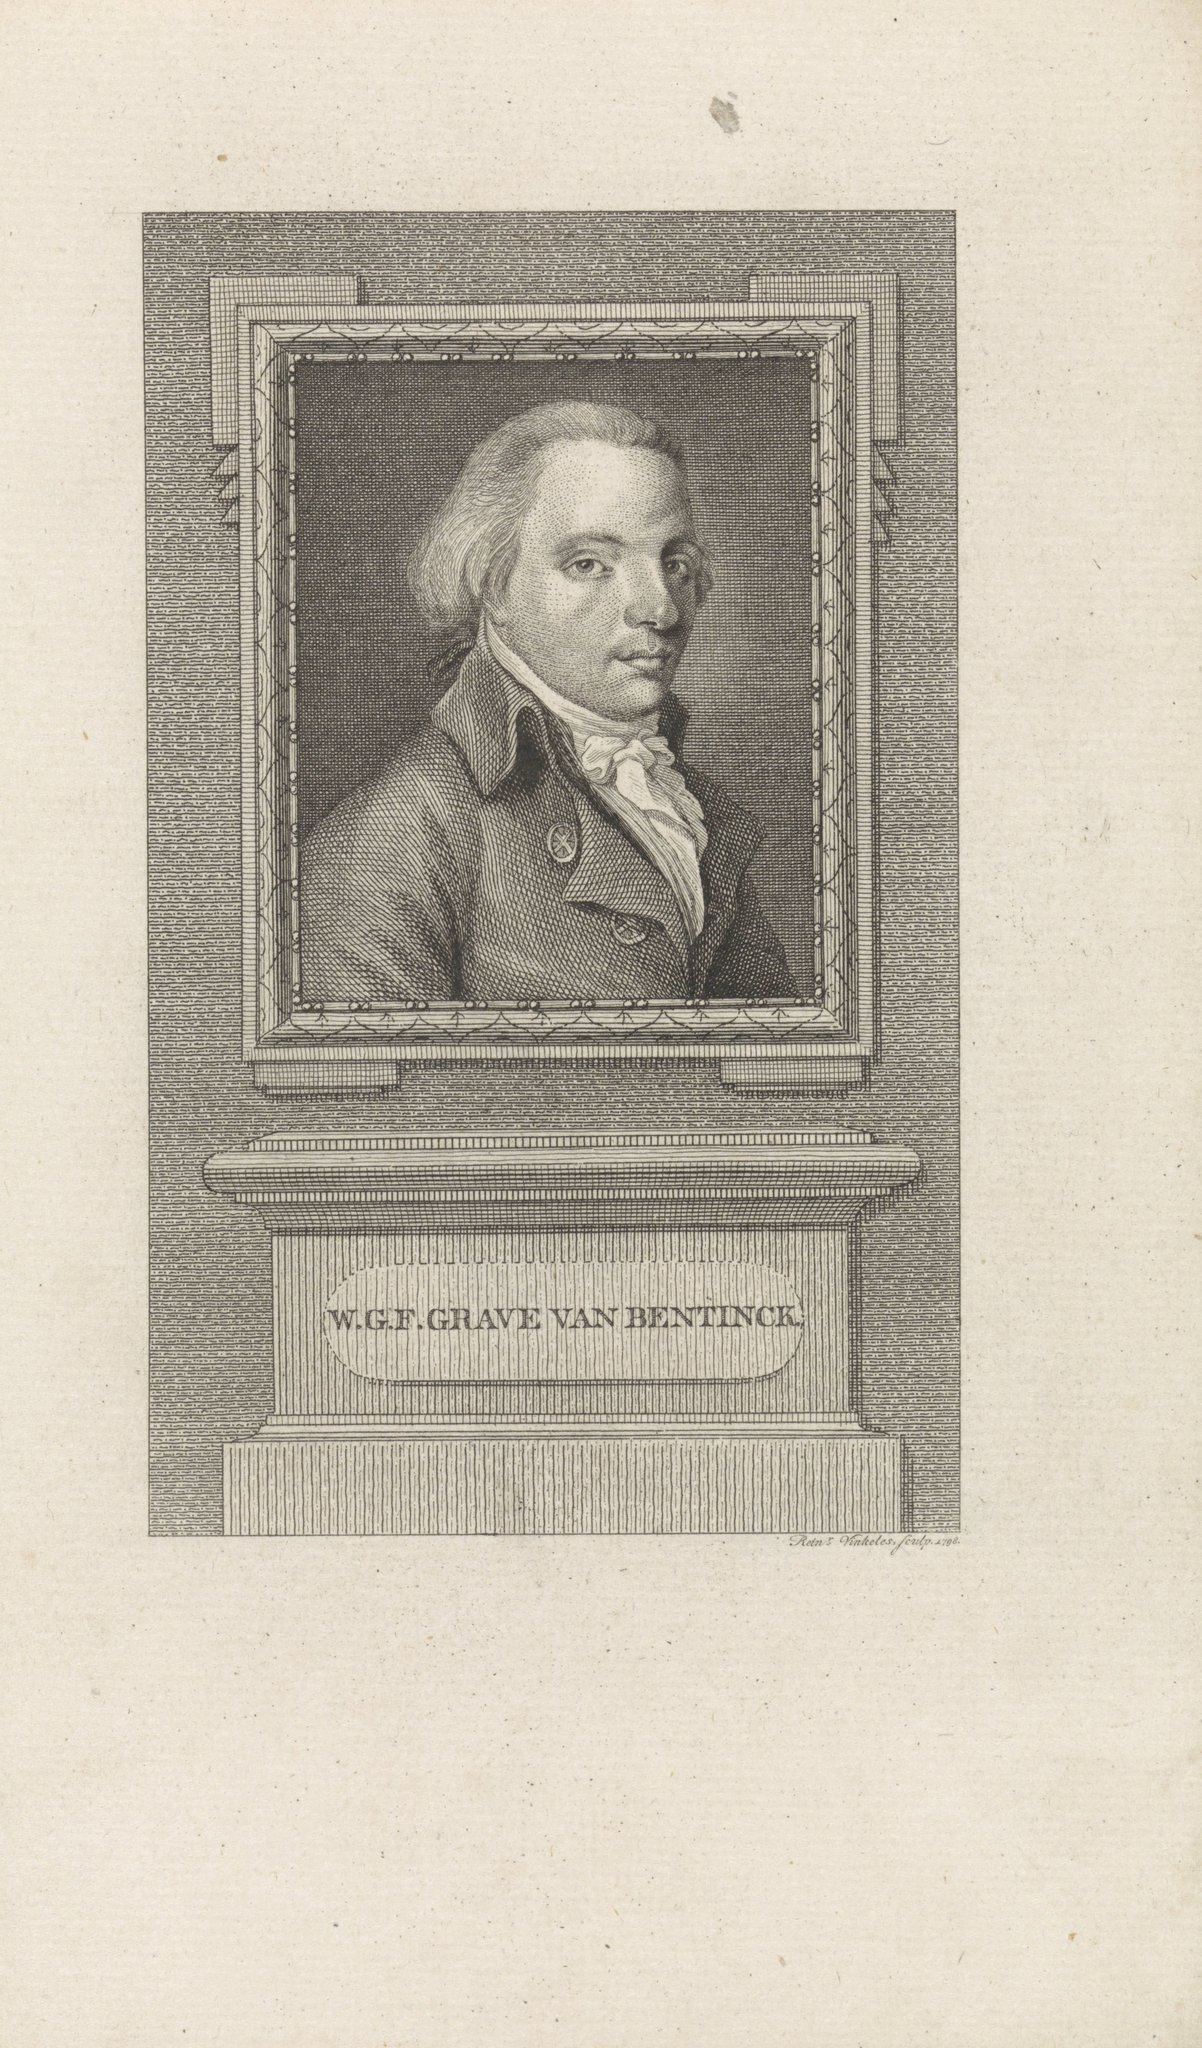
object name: print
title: Portret van Willem Gustaef Frederik Bentinck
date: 1794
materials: paper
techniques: engraving, etching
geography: amsterdam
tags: the hague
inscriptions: collector's mark: Lugt 2228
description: Prent gebruikt als boekillustratie in: Wagenaar, Jan. Vaderlandsche historie, (...) ten vervolge van Wagenaars Vaderlandsche historie. Dl. 1-43. Amsterdam: Johannes Allart, 1786-1809. Twintigste deel, 1798.